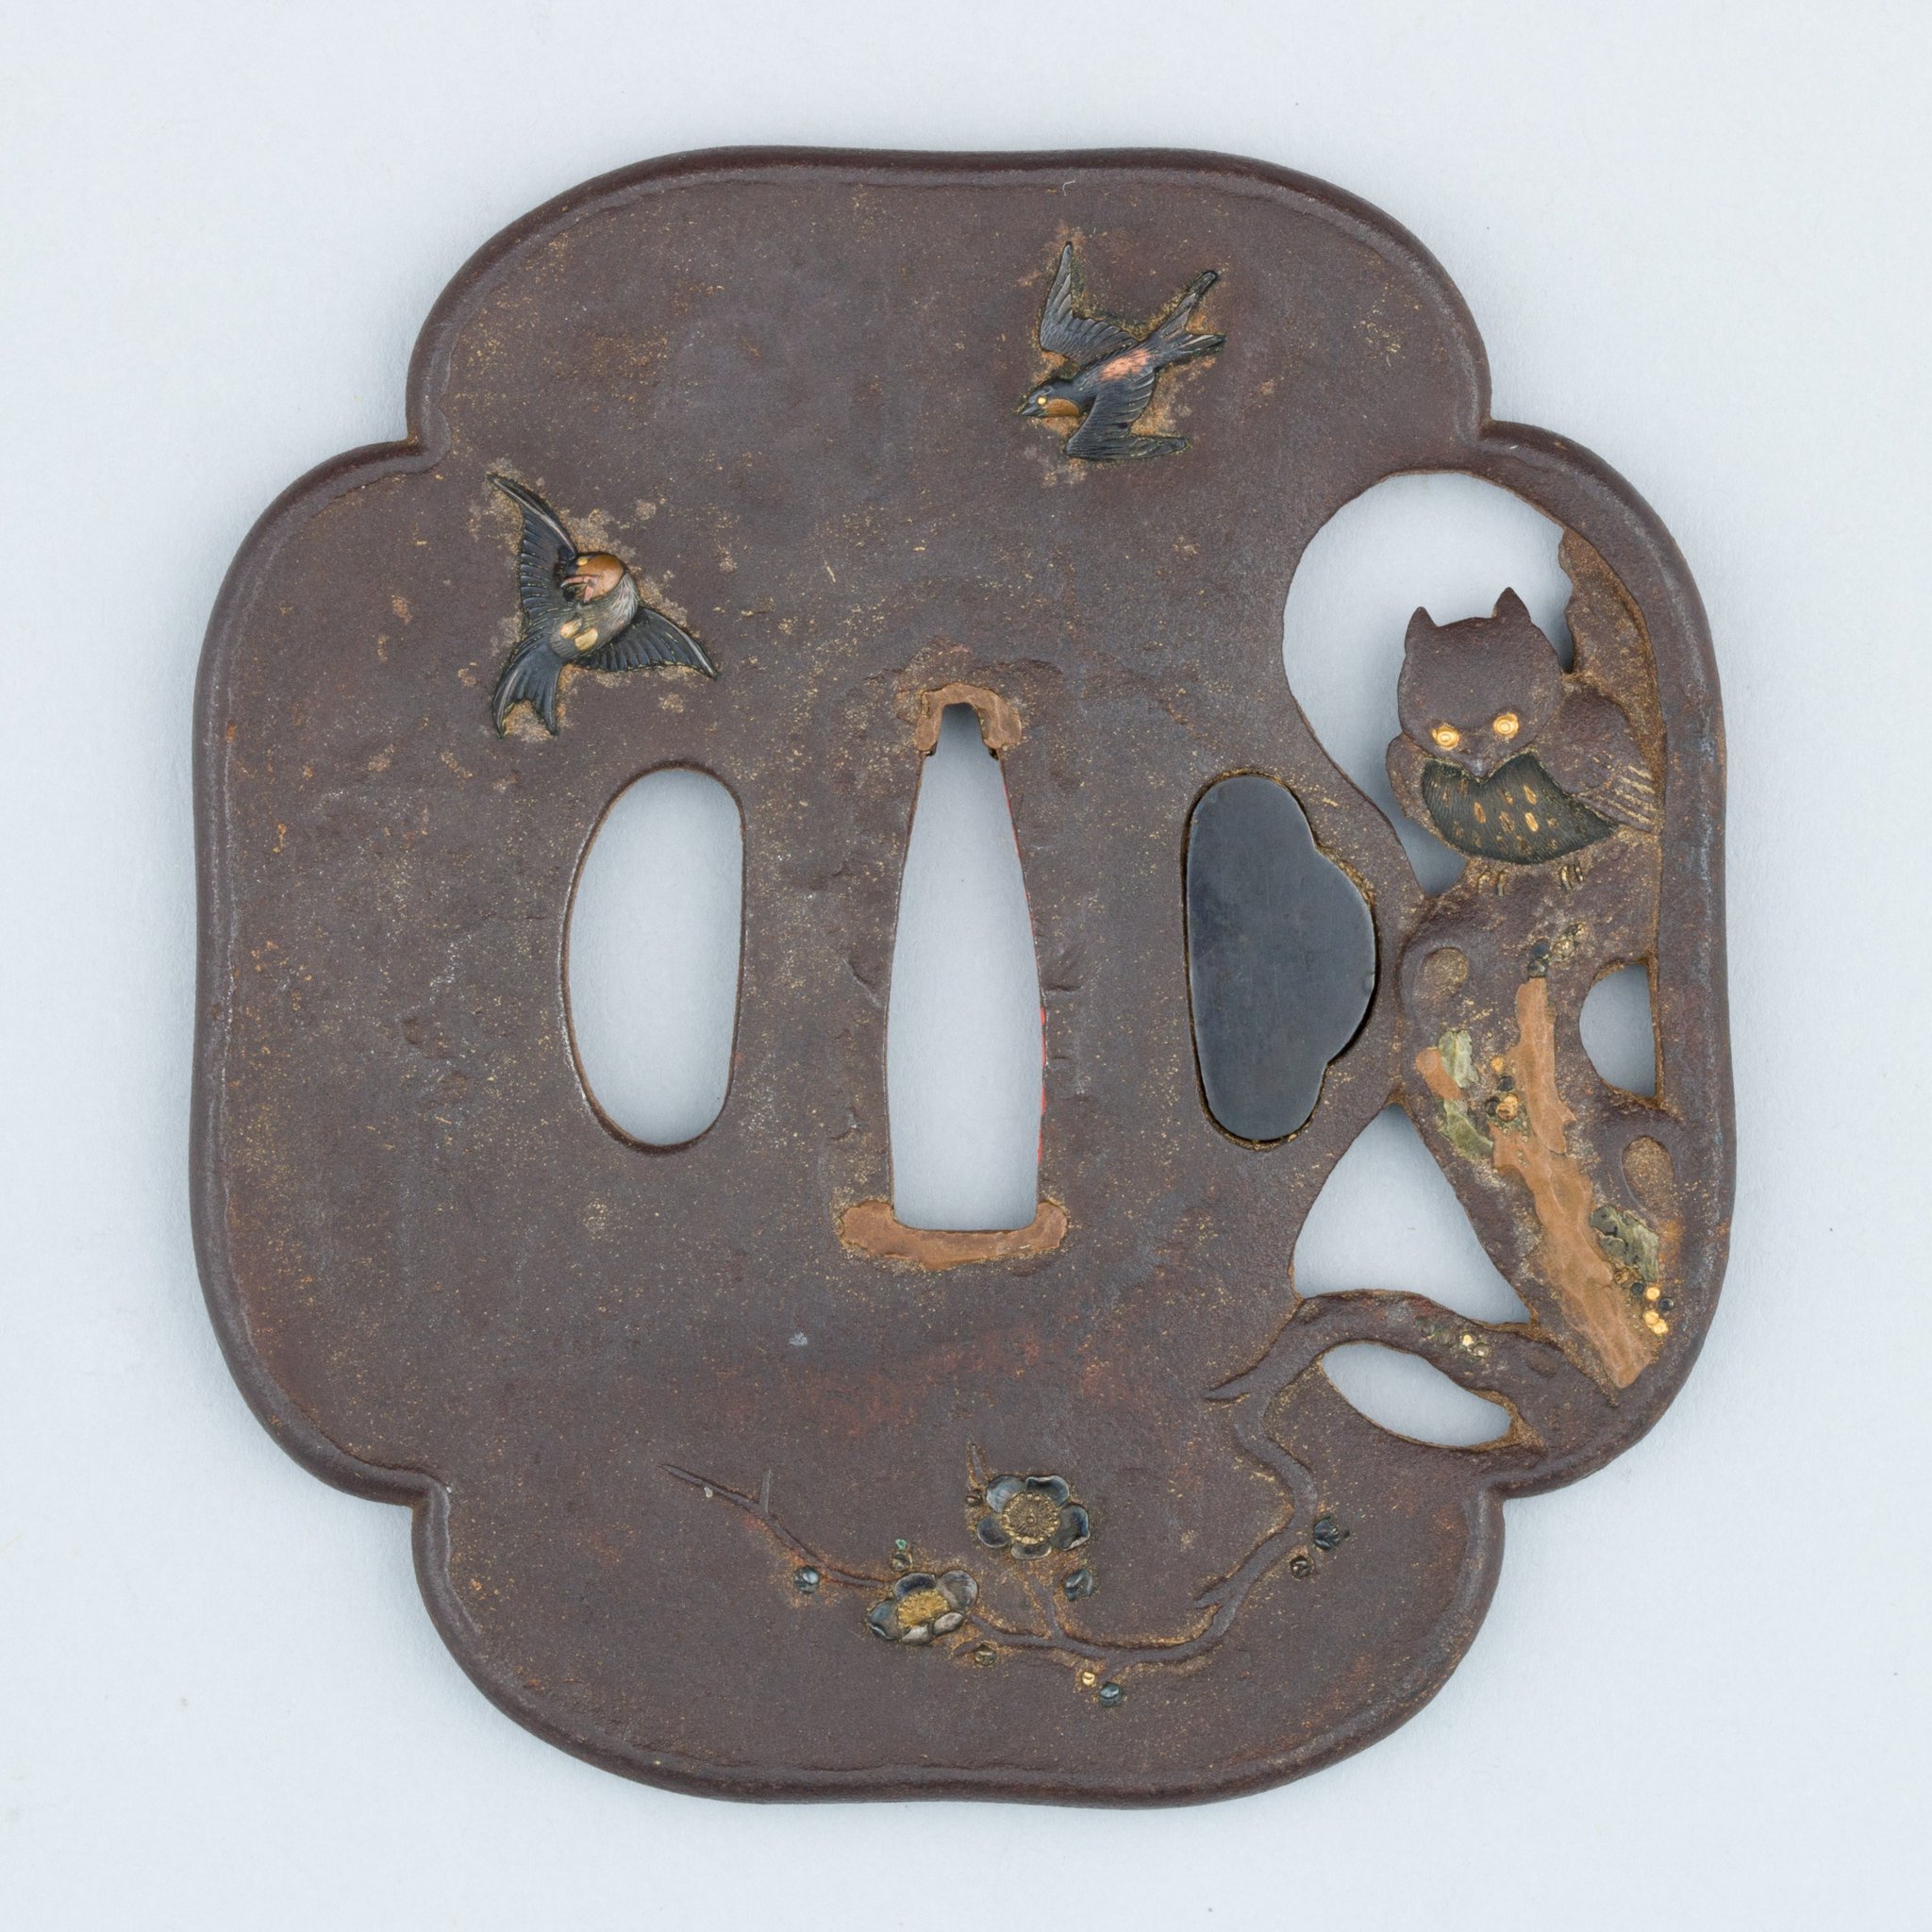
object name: sword guard tsuba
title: Sword Guard (Tsuba)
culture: japanese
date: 1615-1868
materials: copper, gold alloy, silver alloy, gold, iron, silver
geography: japan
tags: birds,owls